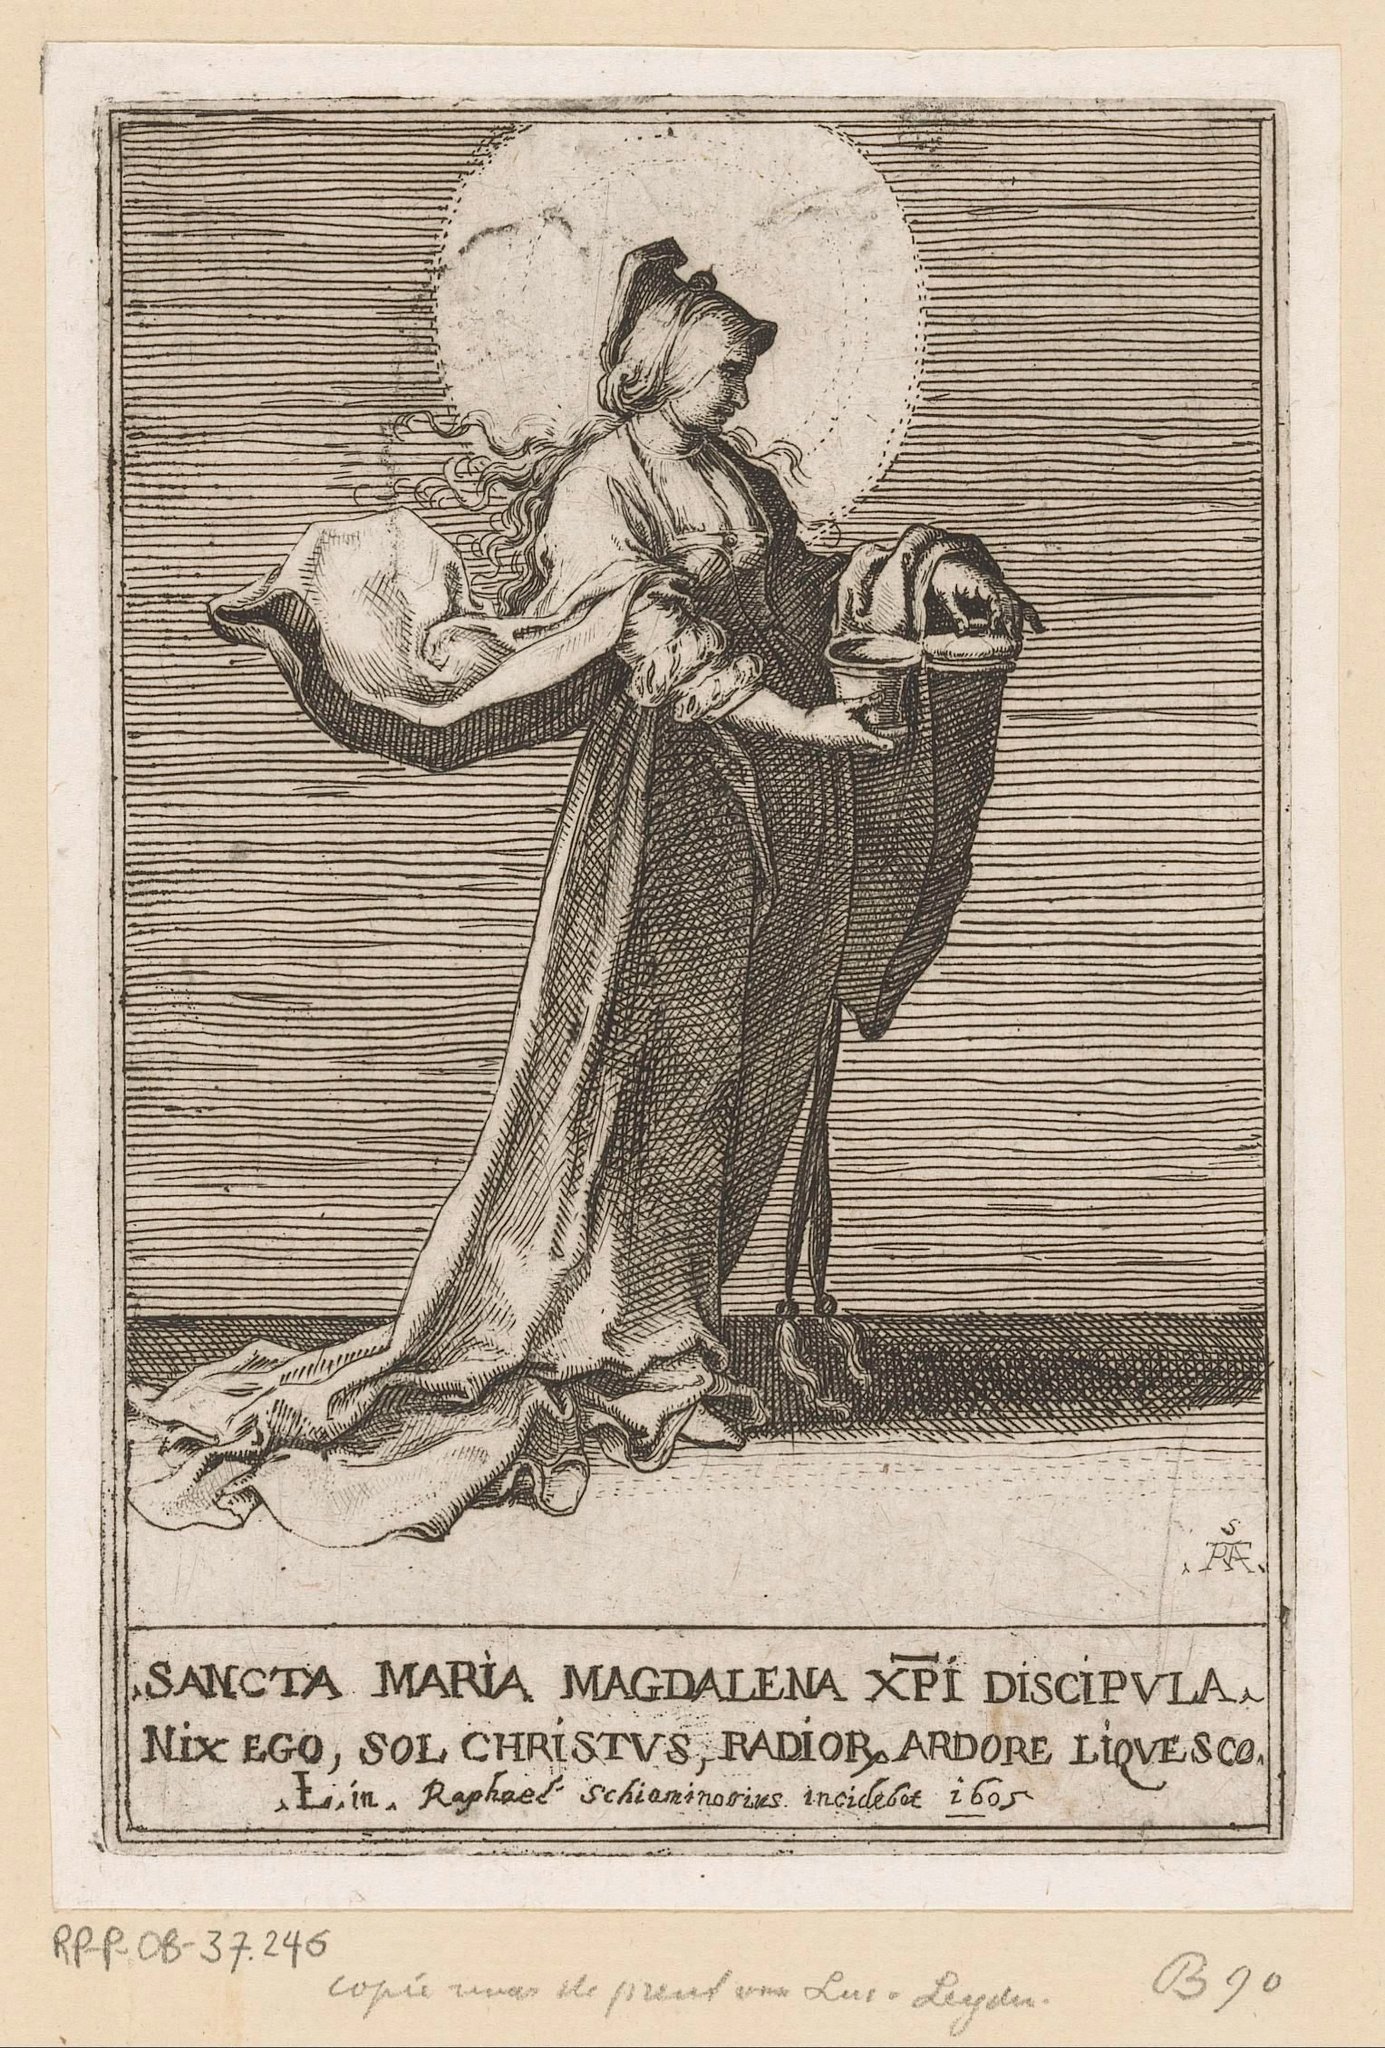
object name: print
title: Maria Magdalena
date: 1605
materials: paper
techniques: etching, intaglio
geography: italy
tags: the penitent harlot mary magdalene; possible attributes: book (or scroll), crown, crown of thorns, crucifix, jar of ointment, mirror, musical instrument, palm-branch, rosary, scourge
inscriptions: collector's mark: Lugt 240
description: De heilige Maria Magdalena, staand en naar rechts gekeerd. In haar handen draagt zij een zalfpot.